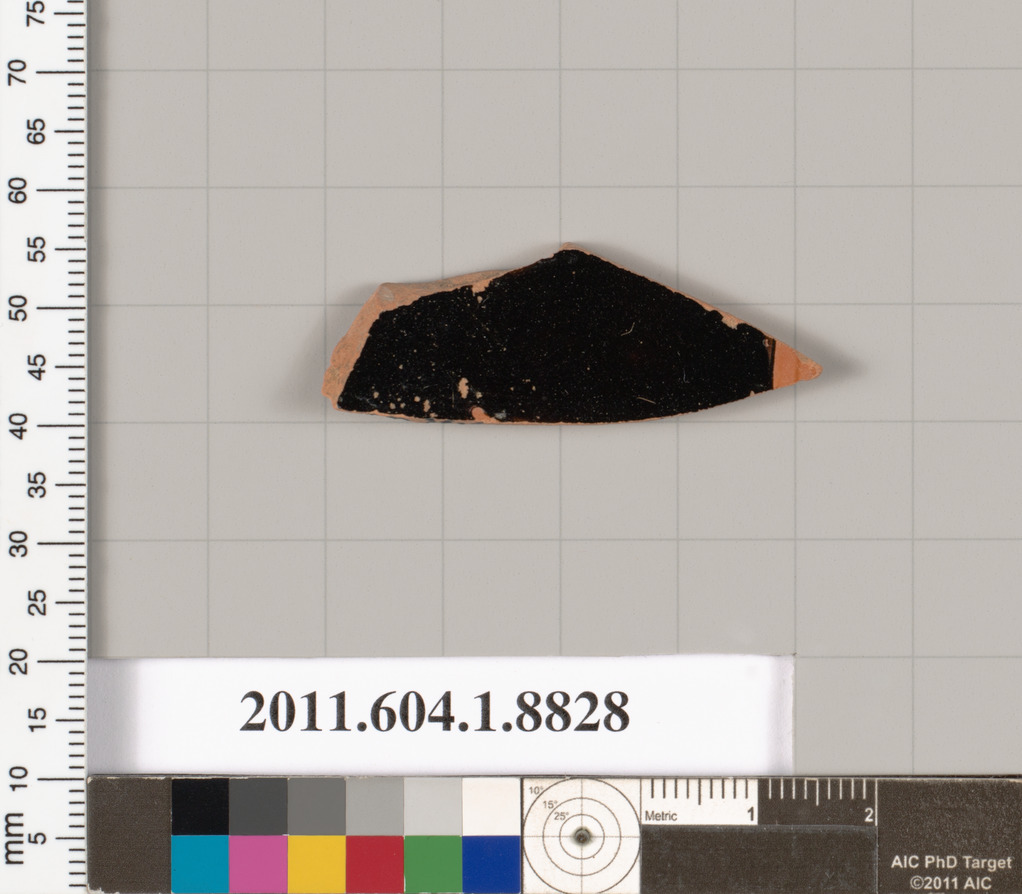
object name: kylix fragment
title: Terracotta fragment of a kylix (drinking cup)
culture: greek, attic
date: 500-470 BCE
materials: terracotta